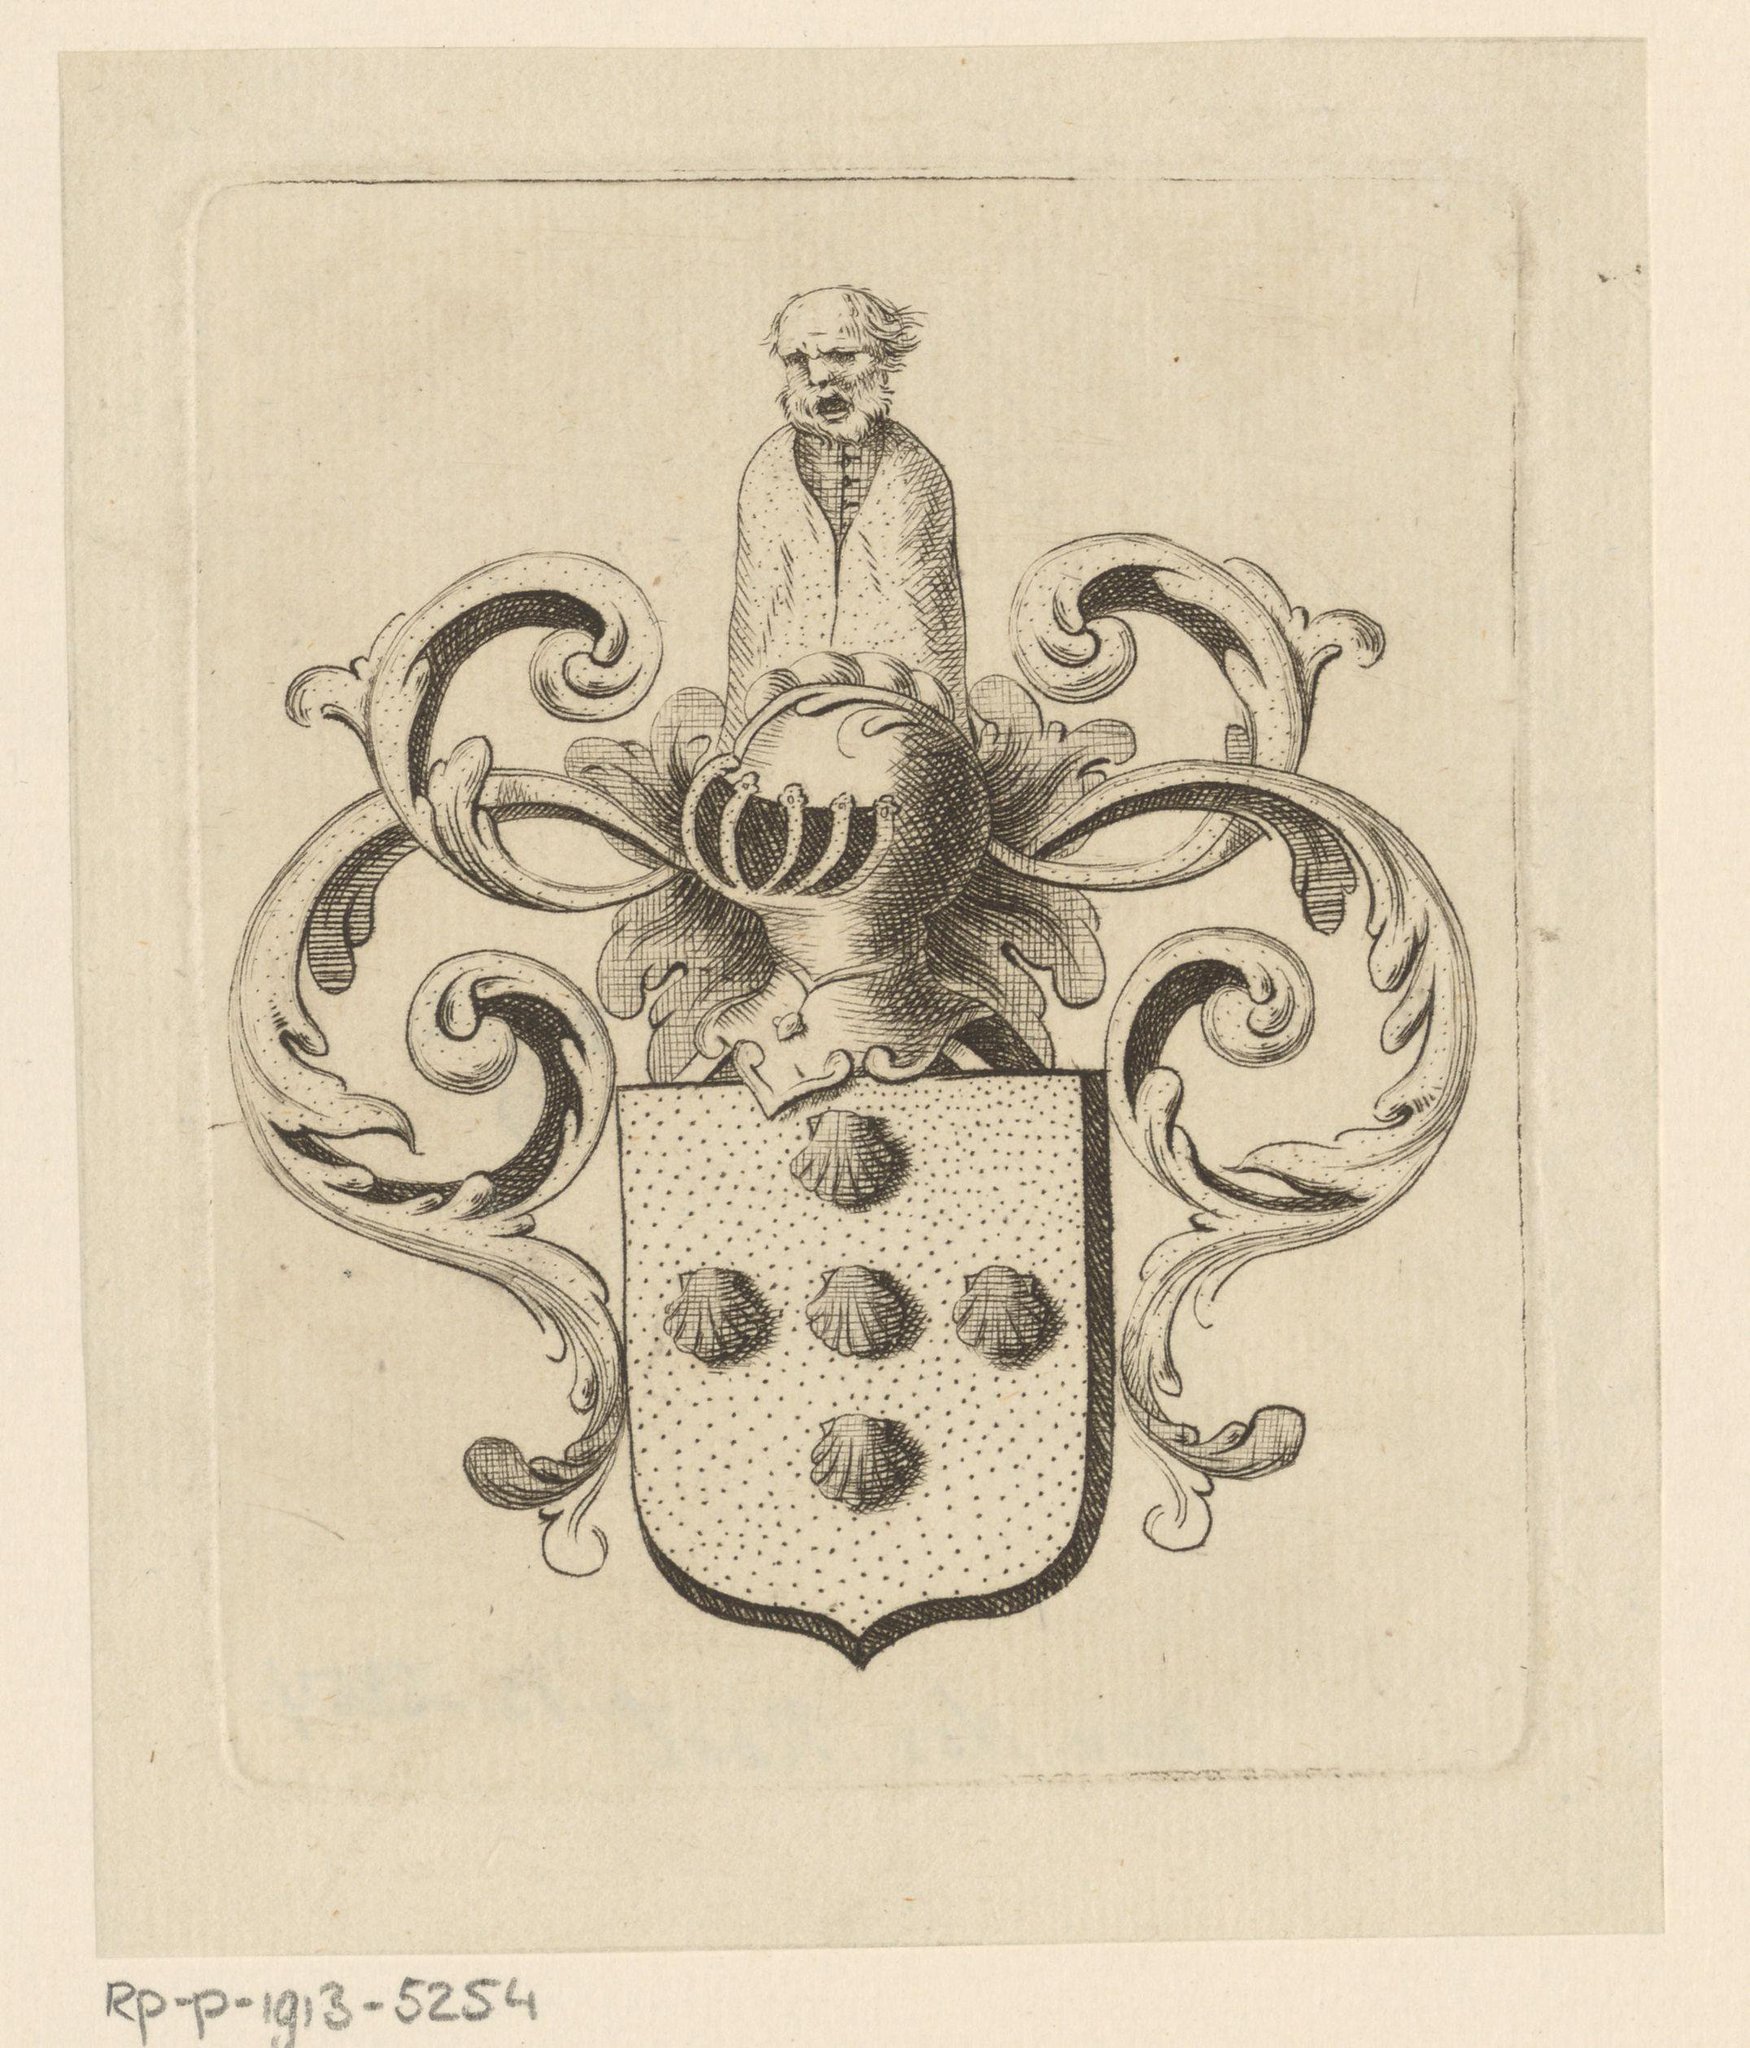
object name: bookplate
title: Ex libris van onbekend, mogelijk Van der Noot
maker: Anonymous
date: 1750-1849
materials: paper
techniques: engraving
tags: armorial bearing, heraldry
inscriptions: collector's mark: Lugt 2760, collector's mark: Lugt 2233